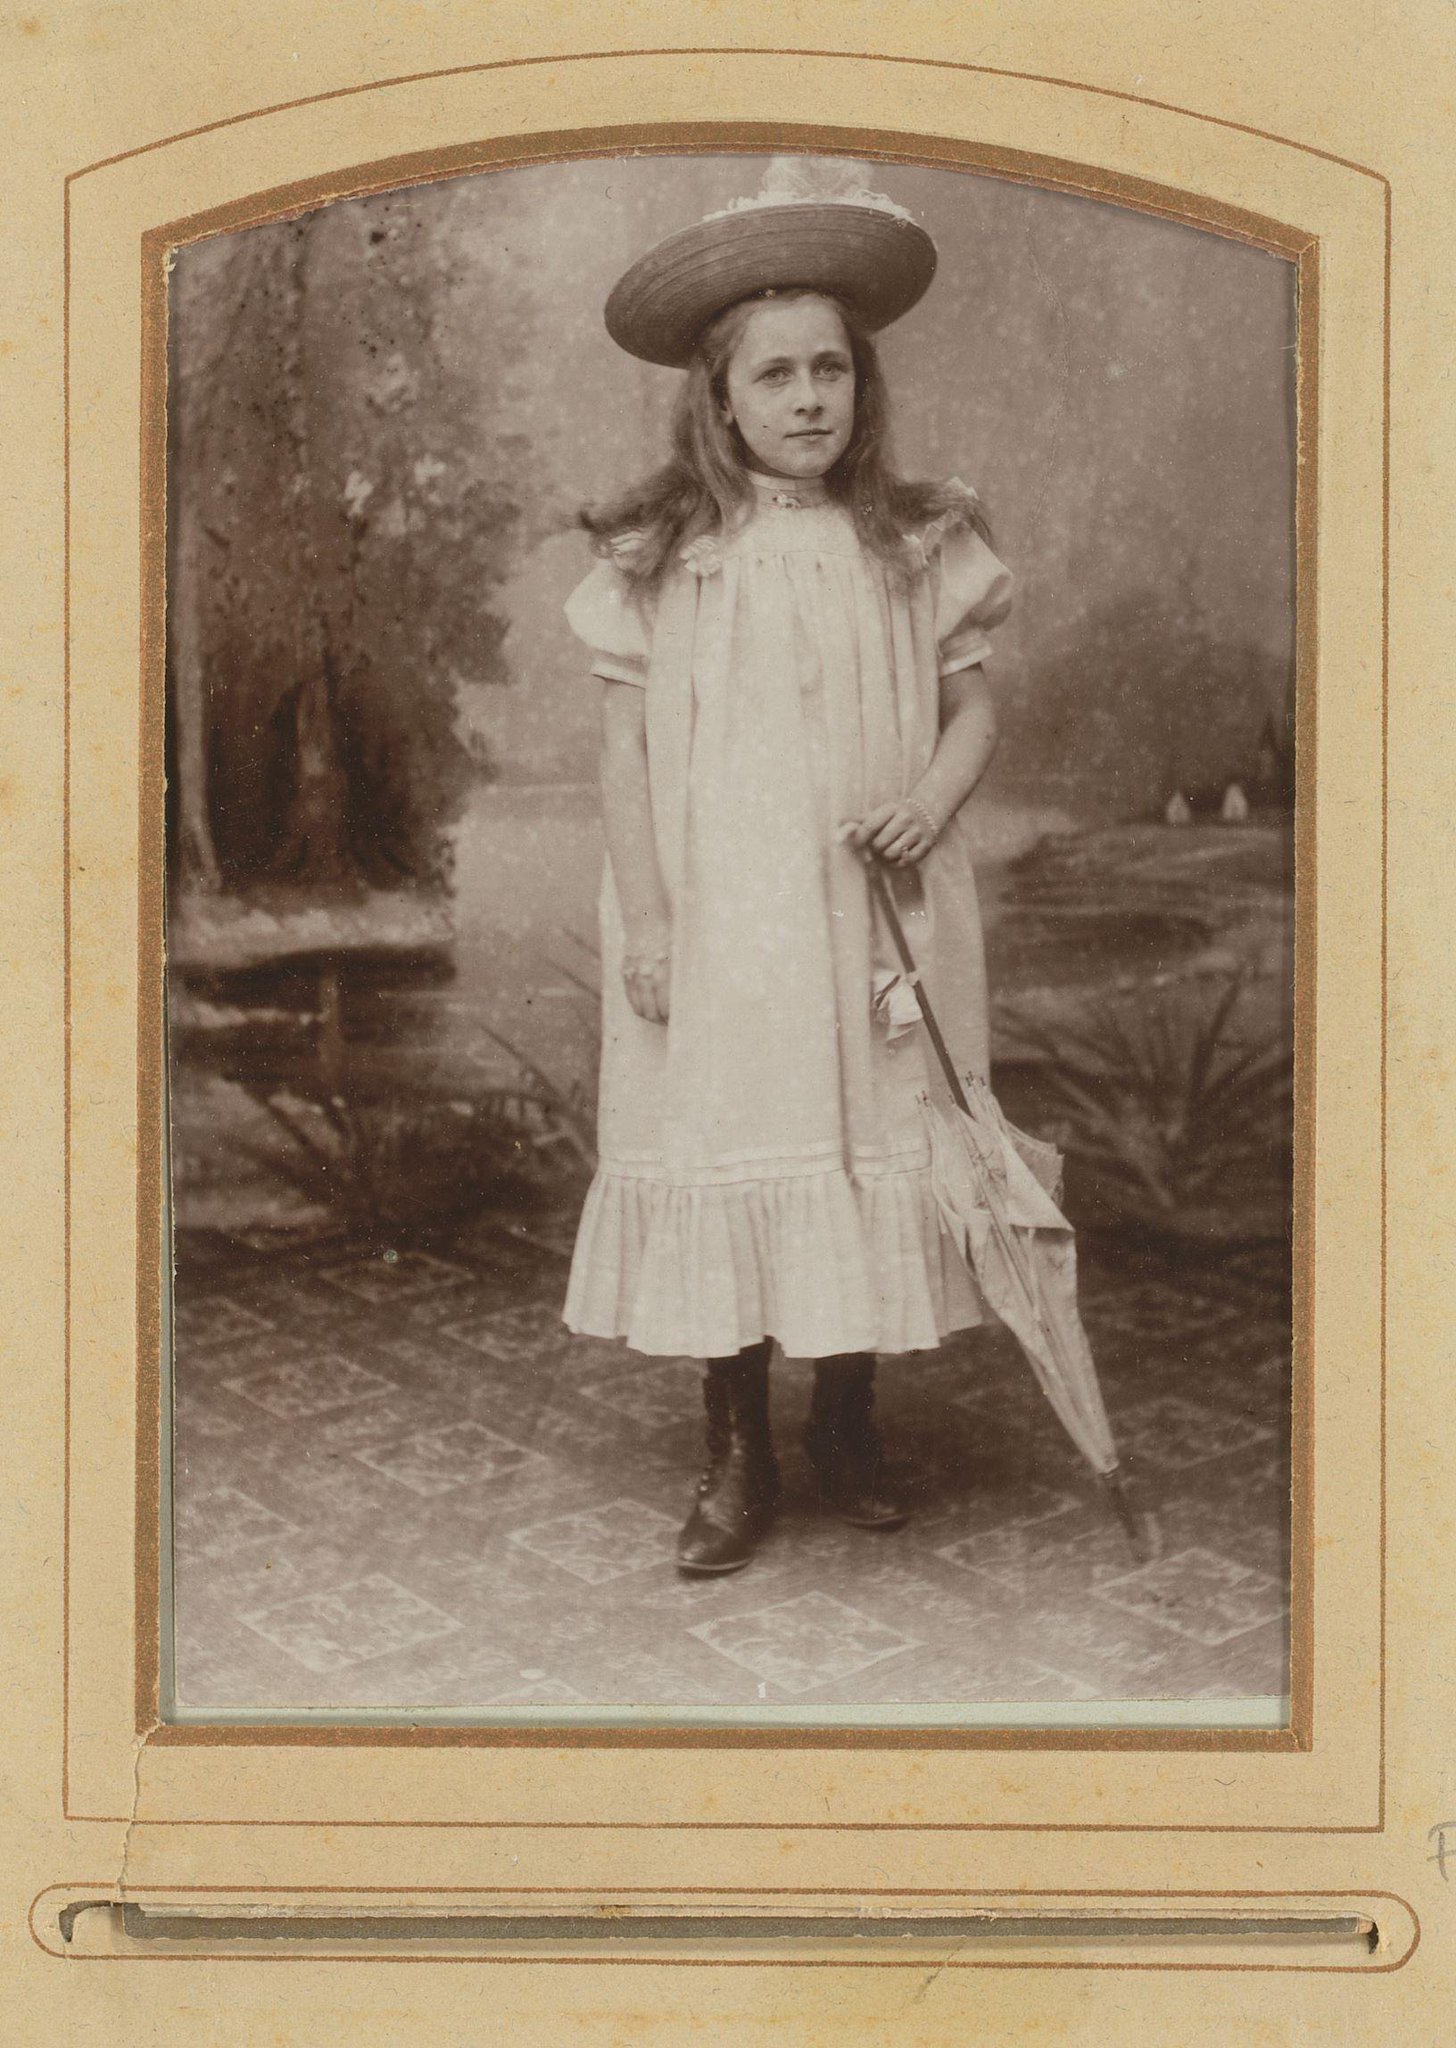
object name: cabinet photograph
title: Portret van een staand meisje met hoed en parasol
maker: nicolaas broekhuizen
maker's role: fotograaf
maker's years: 1867-1920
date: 1901-1909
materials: cardboard, photographic support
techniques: collodion silver print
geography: gouda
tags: historical persons - bb - woman, girl (child between toddler and youth), head-gear: hat, parasol, sunshade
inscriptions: inscription: ‘Broekhuizen/ GOUDA./ Kattensingel 62.’